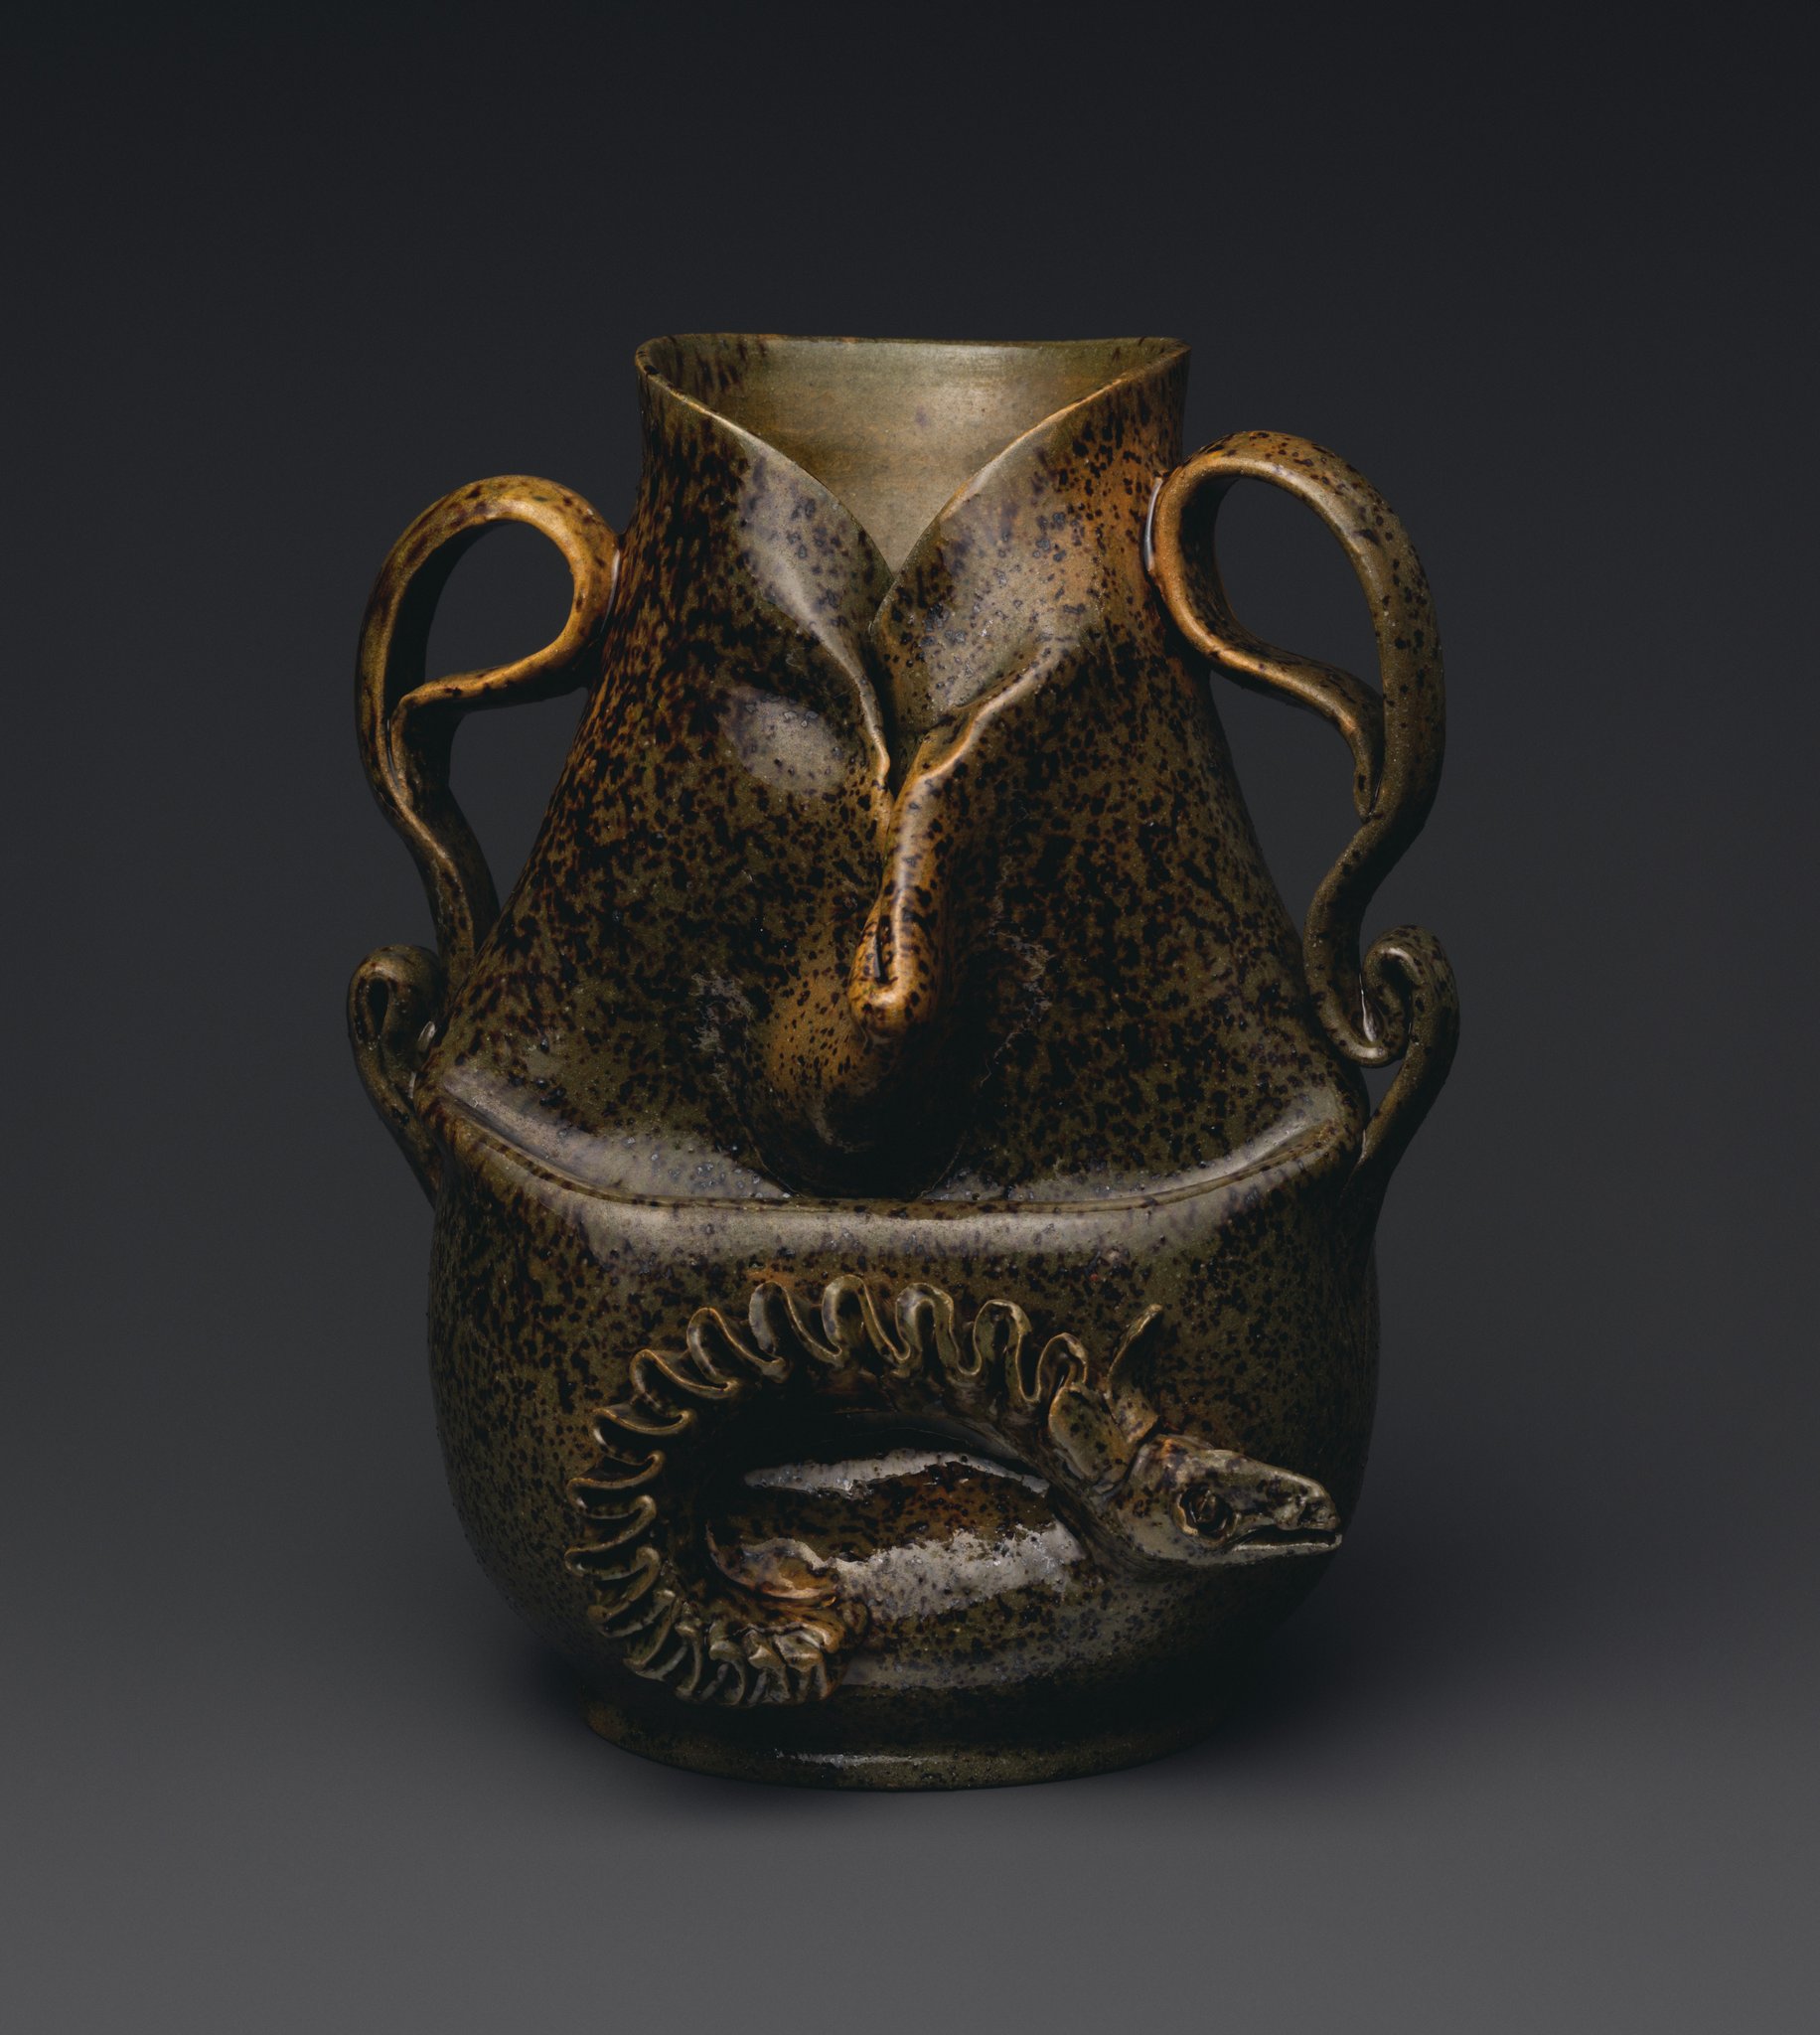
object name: pitcher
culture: american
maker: george e. ohr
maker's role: maker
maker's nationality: american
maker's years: 1857-1918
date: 1896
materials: earthenware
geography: united states